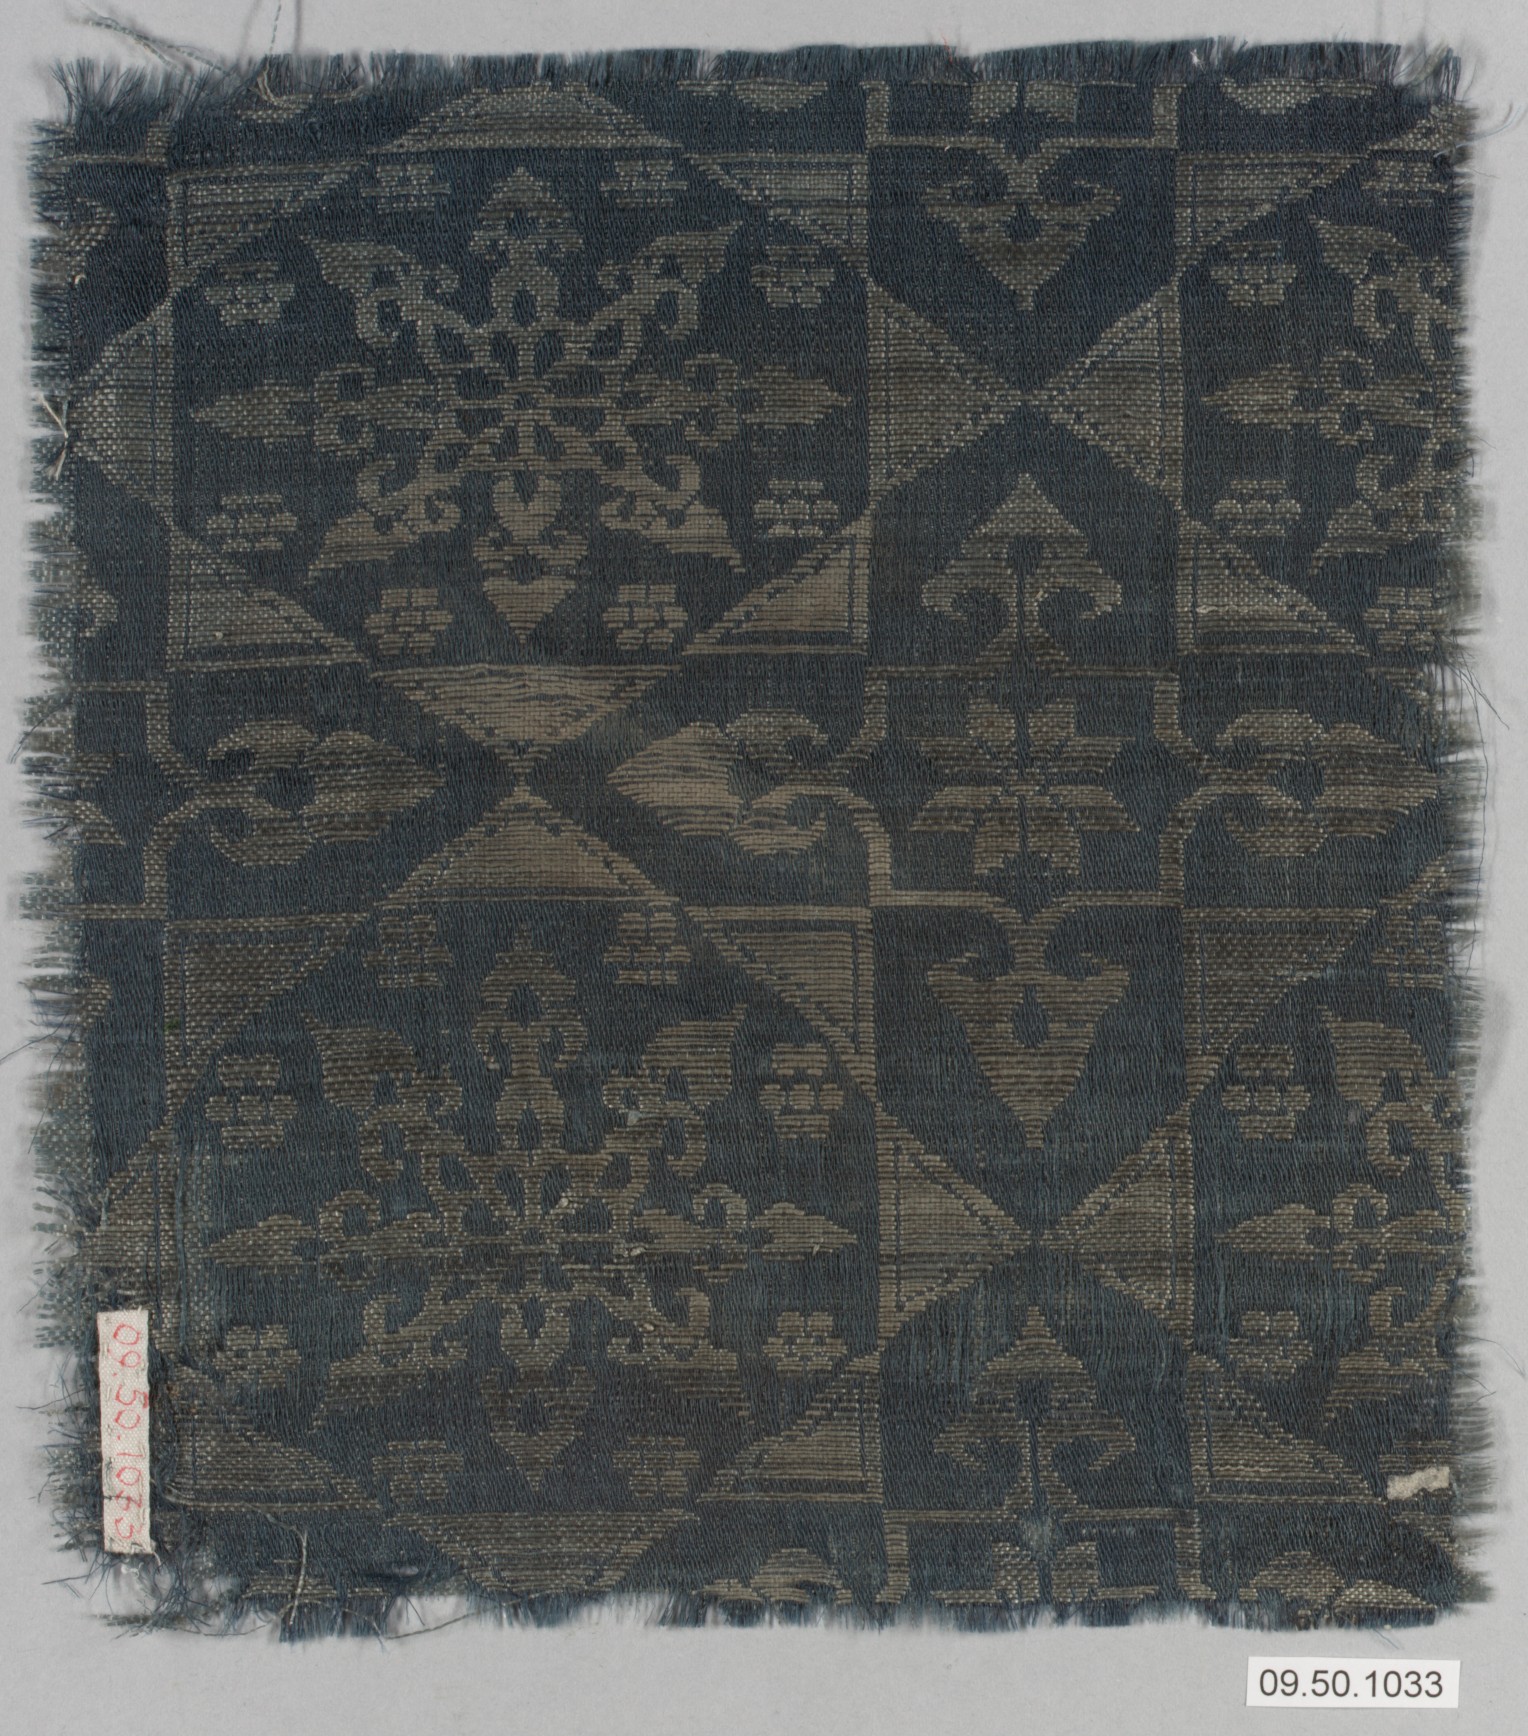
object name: textile fragment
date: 1501-1800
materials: silk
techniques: embroidery, weave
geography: spain